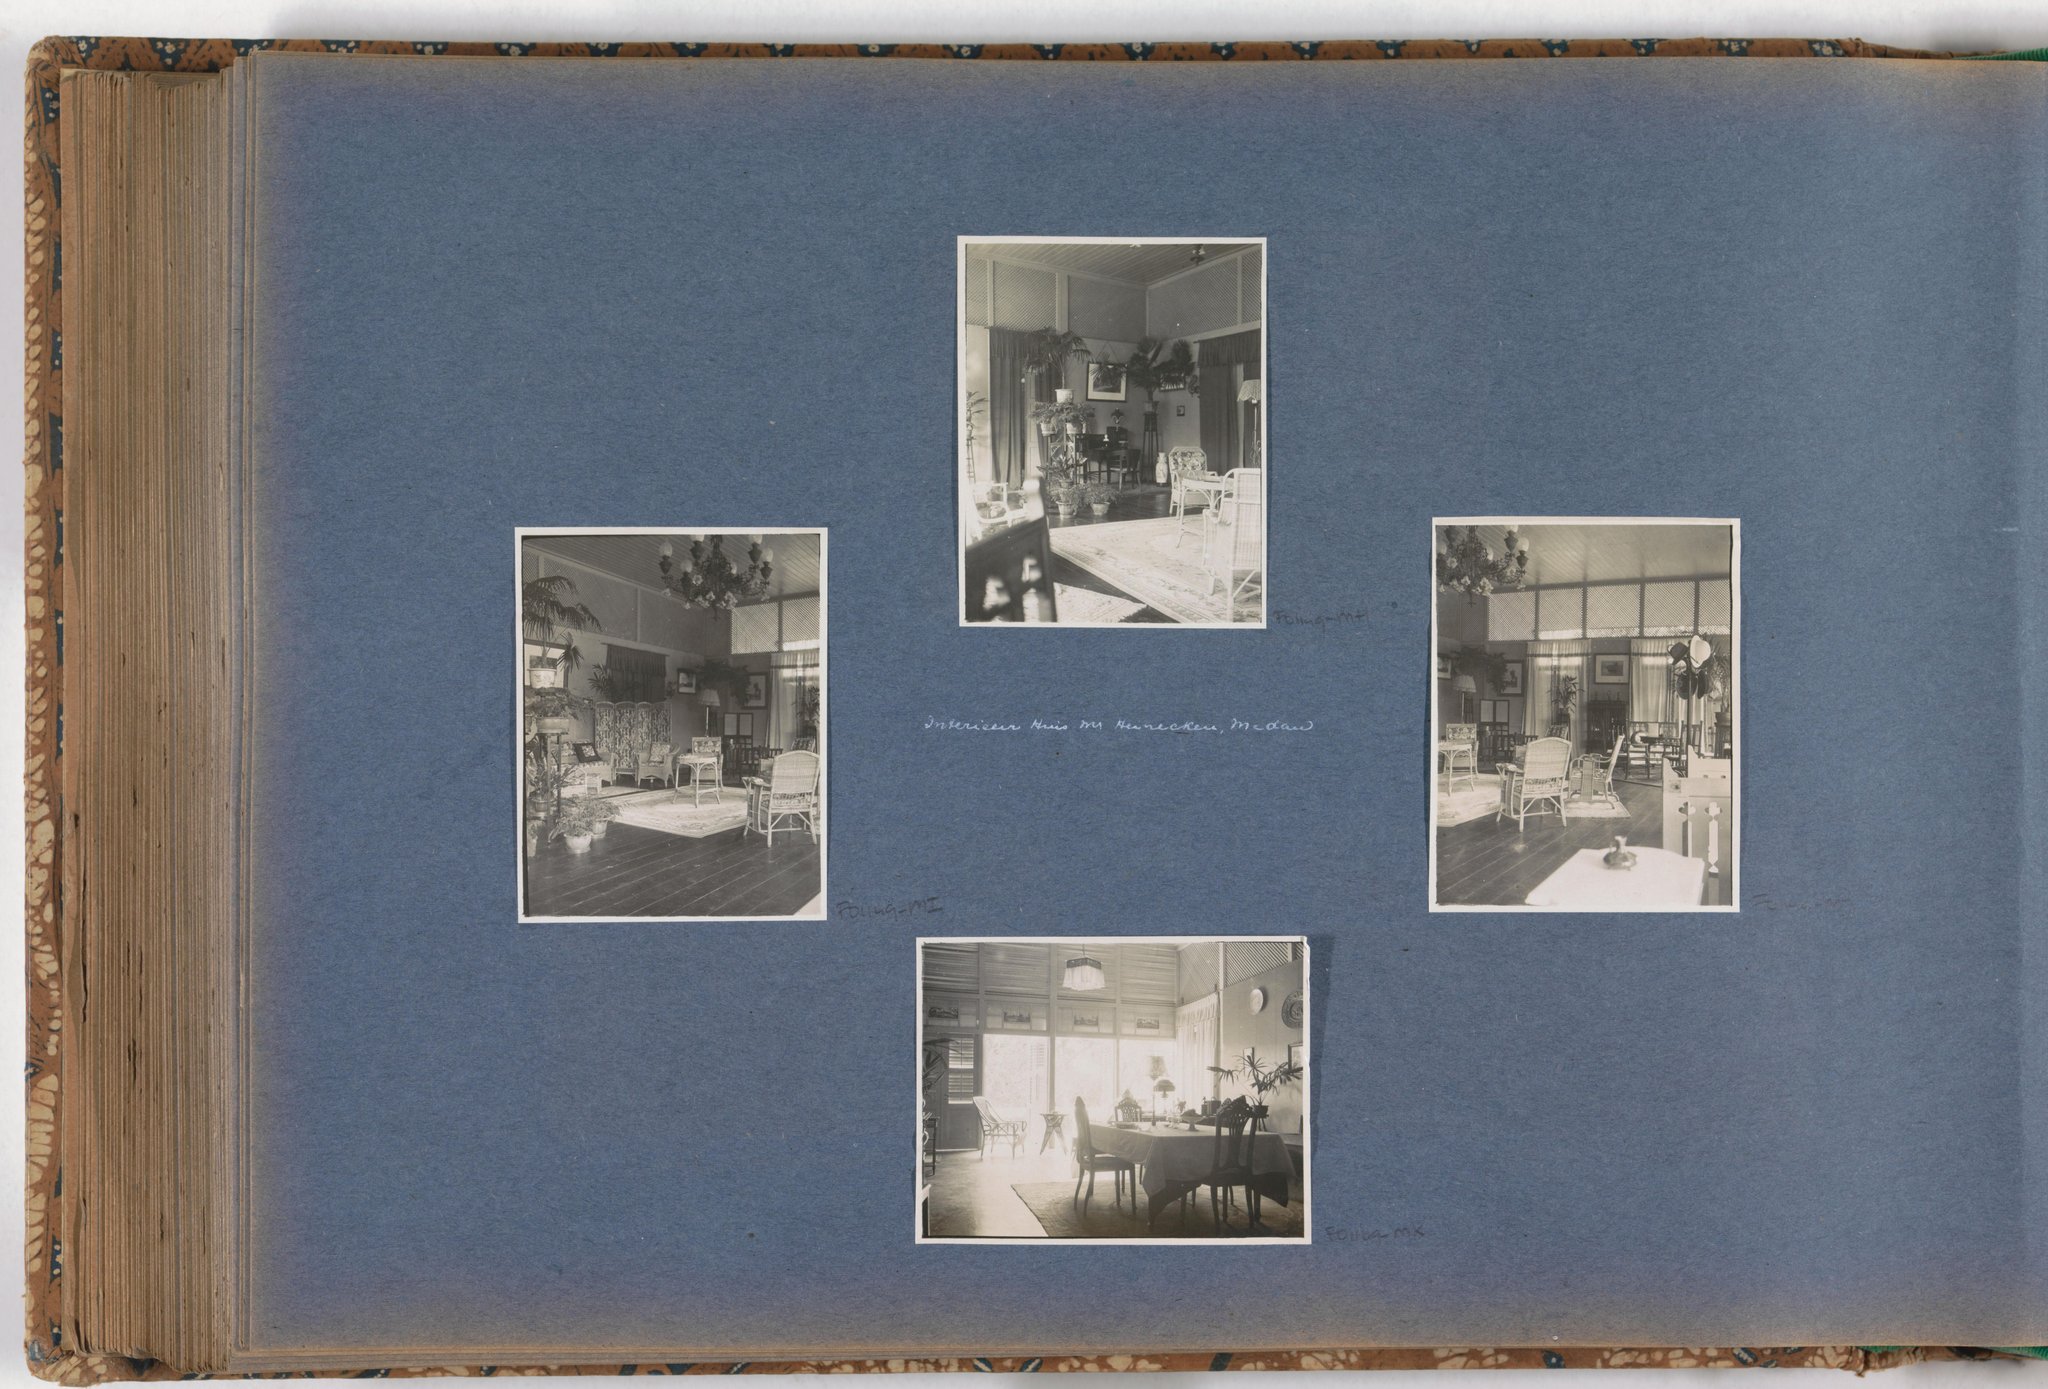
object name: album leaf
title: Interieur van het huis van de heer Heinecken in Medan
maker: Anonymous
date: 1900-1920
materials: paper, photographic support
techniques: gelatin silver print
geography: medan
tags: interior of the house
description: Onderdeel van reisalbum met foto's van bedrijvigheid en bezienswaardigheden op Sumatra en Java en van de reis naar en van Nederlands-Indië.